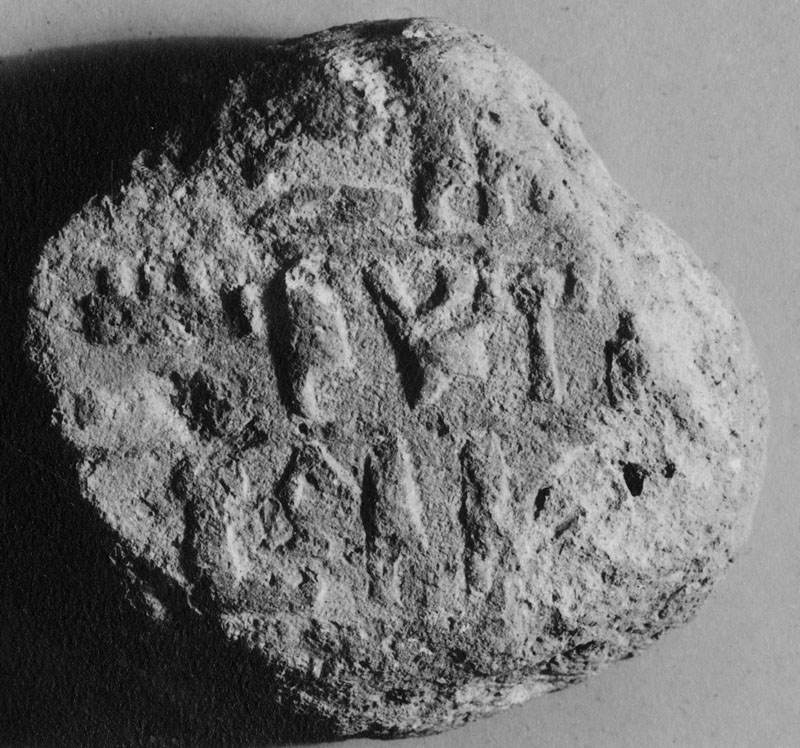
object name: cone, mery, circular impression, scribe, treasury, amun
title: Funerary Cone of the Scribe of the Treasury of Amun Mery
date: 1550-1295 BCE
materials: pottery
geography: egypt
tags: hieroglyphs